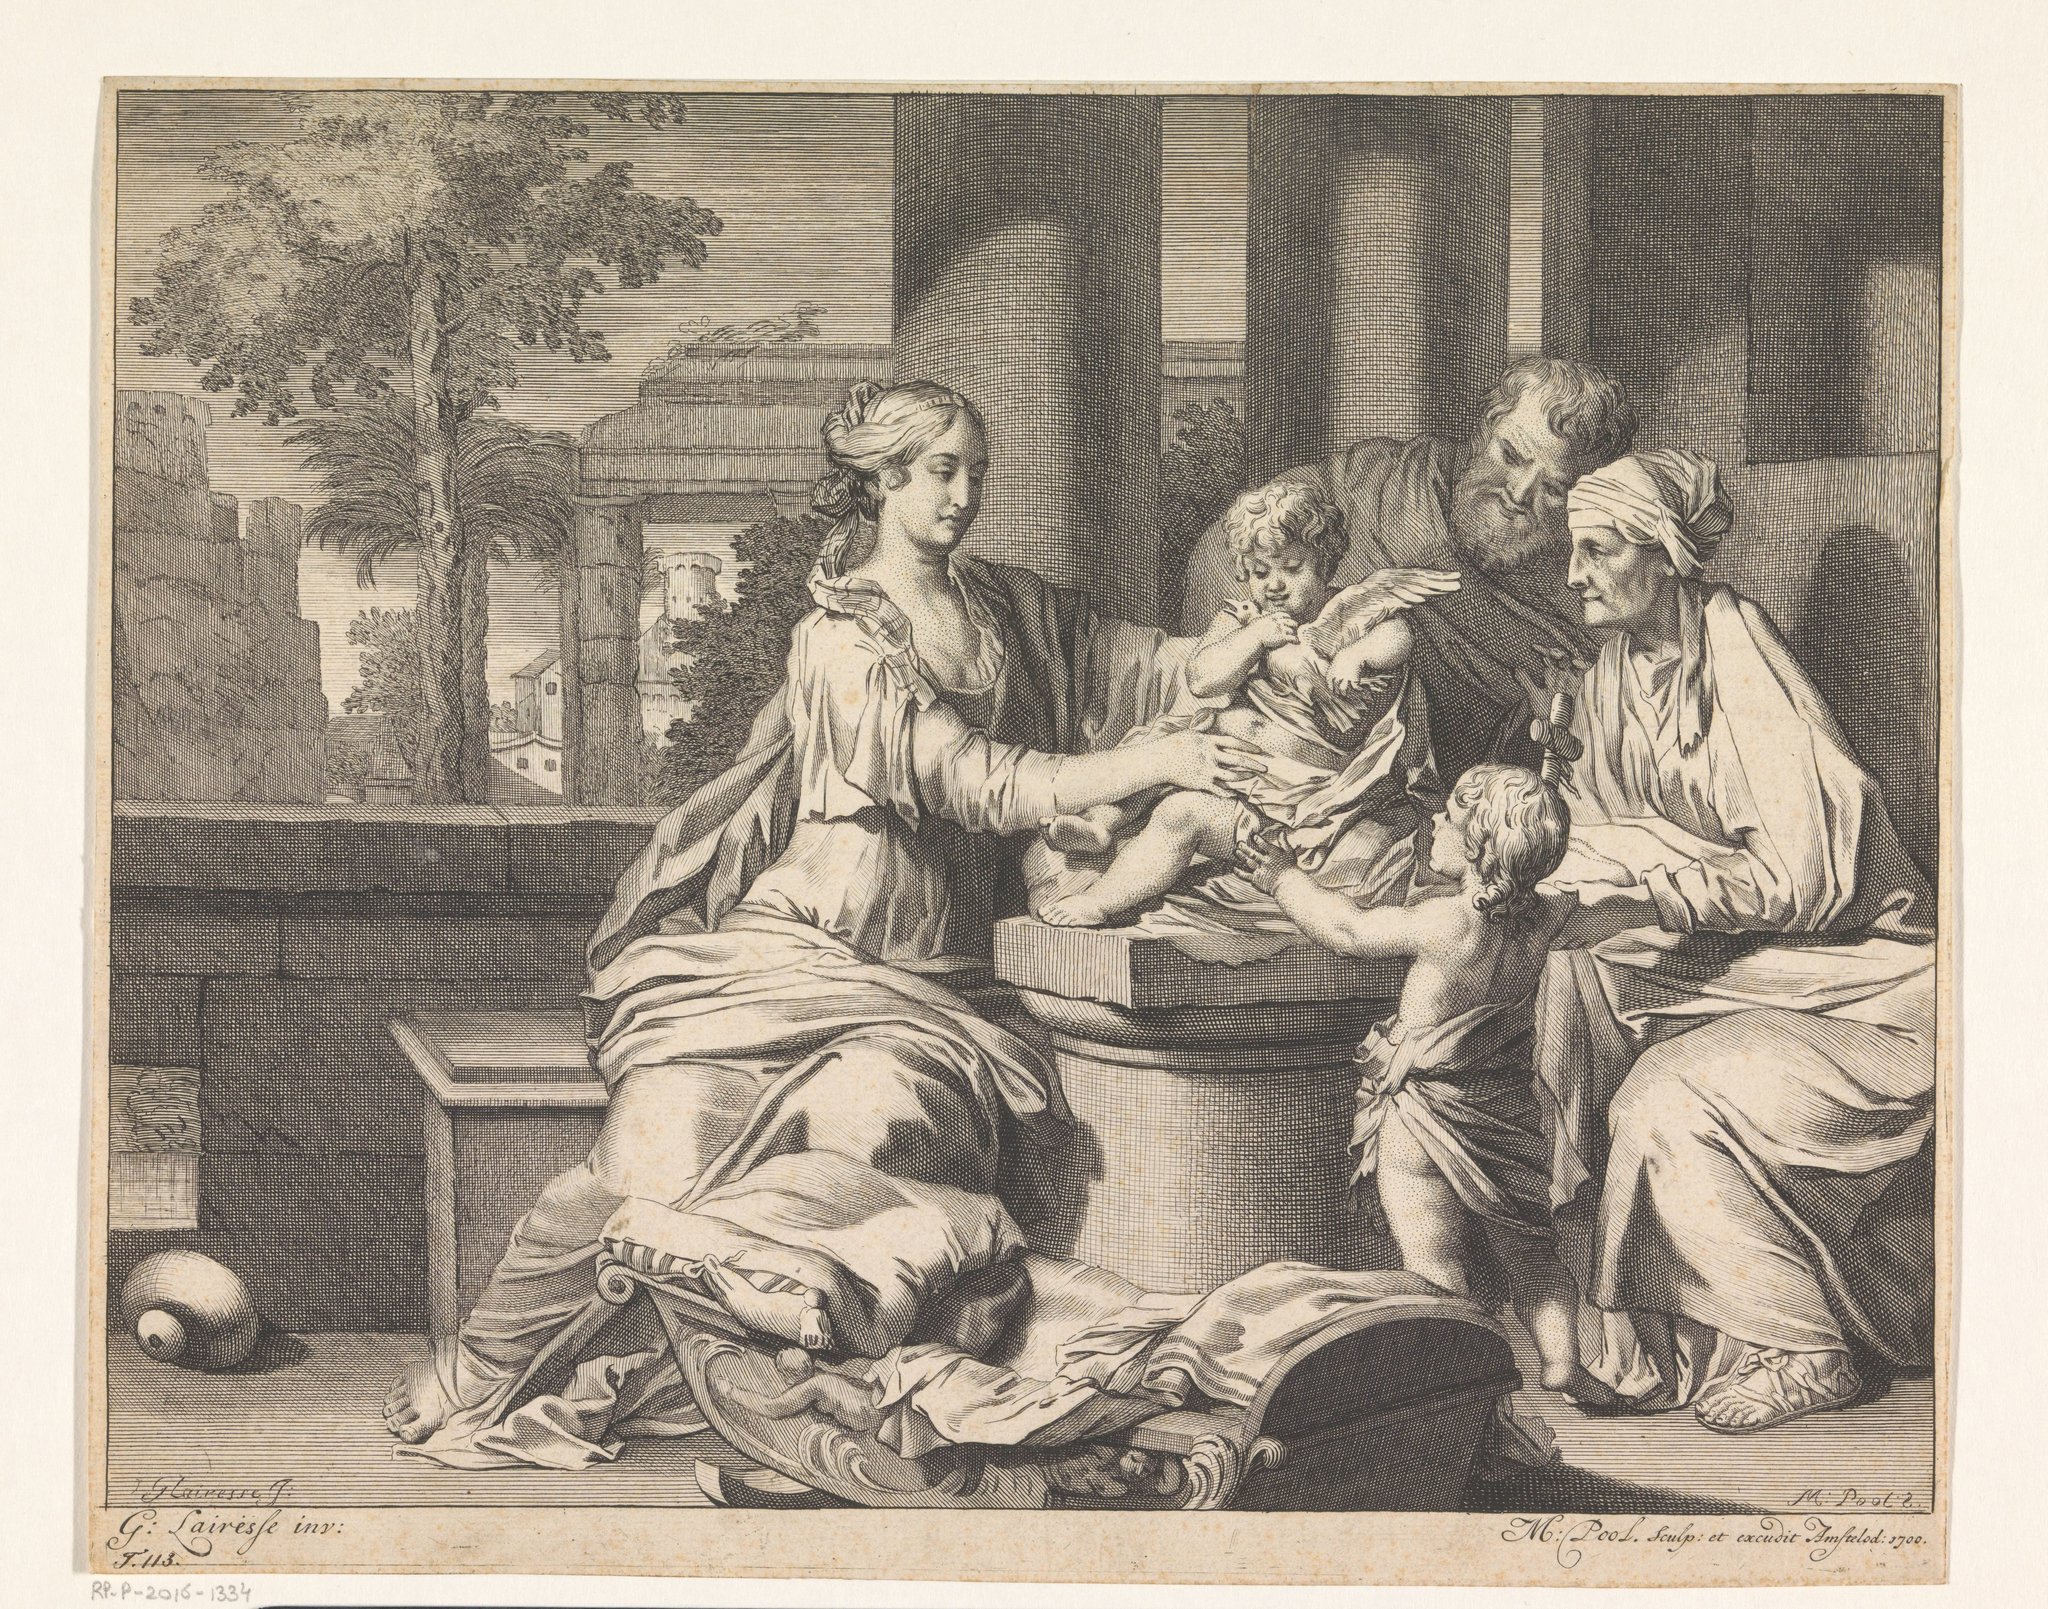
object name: print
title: Heilige Familie met Zacharias, Elisabet en Johannes de Doper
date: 1700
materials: paper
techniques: engraving, etching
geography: amsterdam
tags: symbols and prefigurations of mary, holy family, and derived representations, cradle, crib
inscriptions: collector's mark: ‘Hinloopen’, number: ‘T.113’, collector's mark: Lugt 11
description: Maria zet het Christuskind op een offerzuil. Hij heeft een duif in zijn handen. Zacharias en Elisabet kijken toe. Johannes de Doper reikt naar het Christuskind. Op de voorgrond staat de wieg.